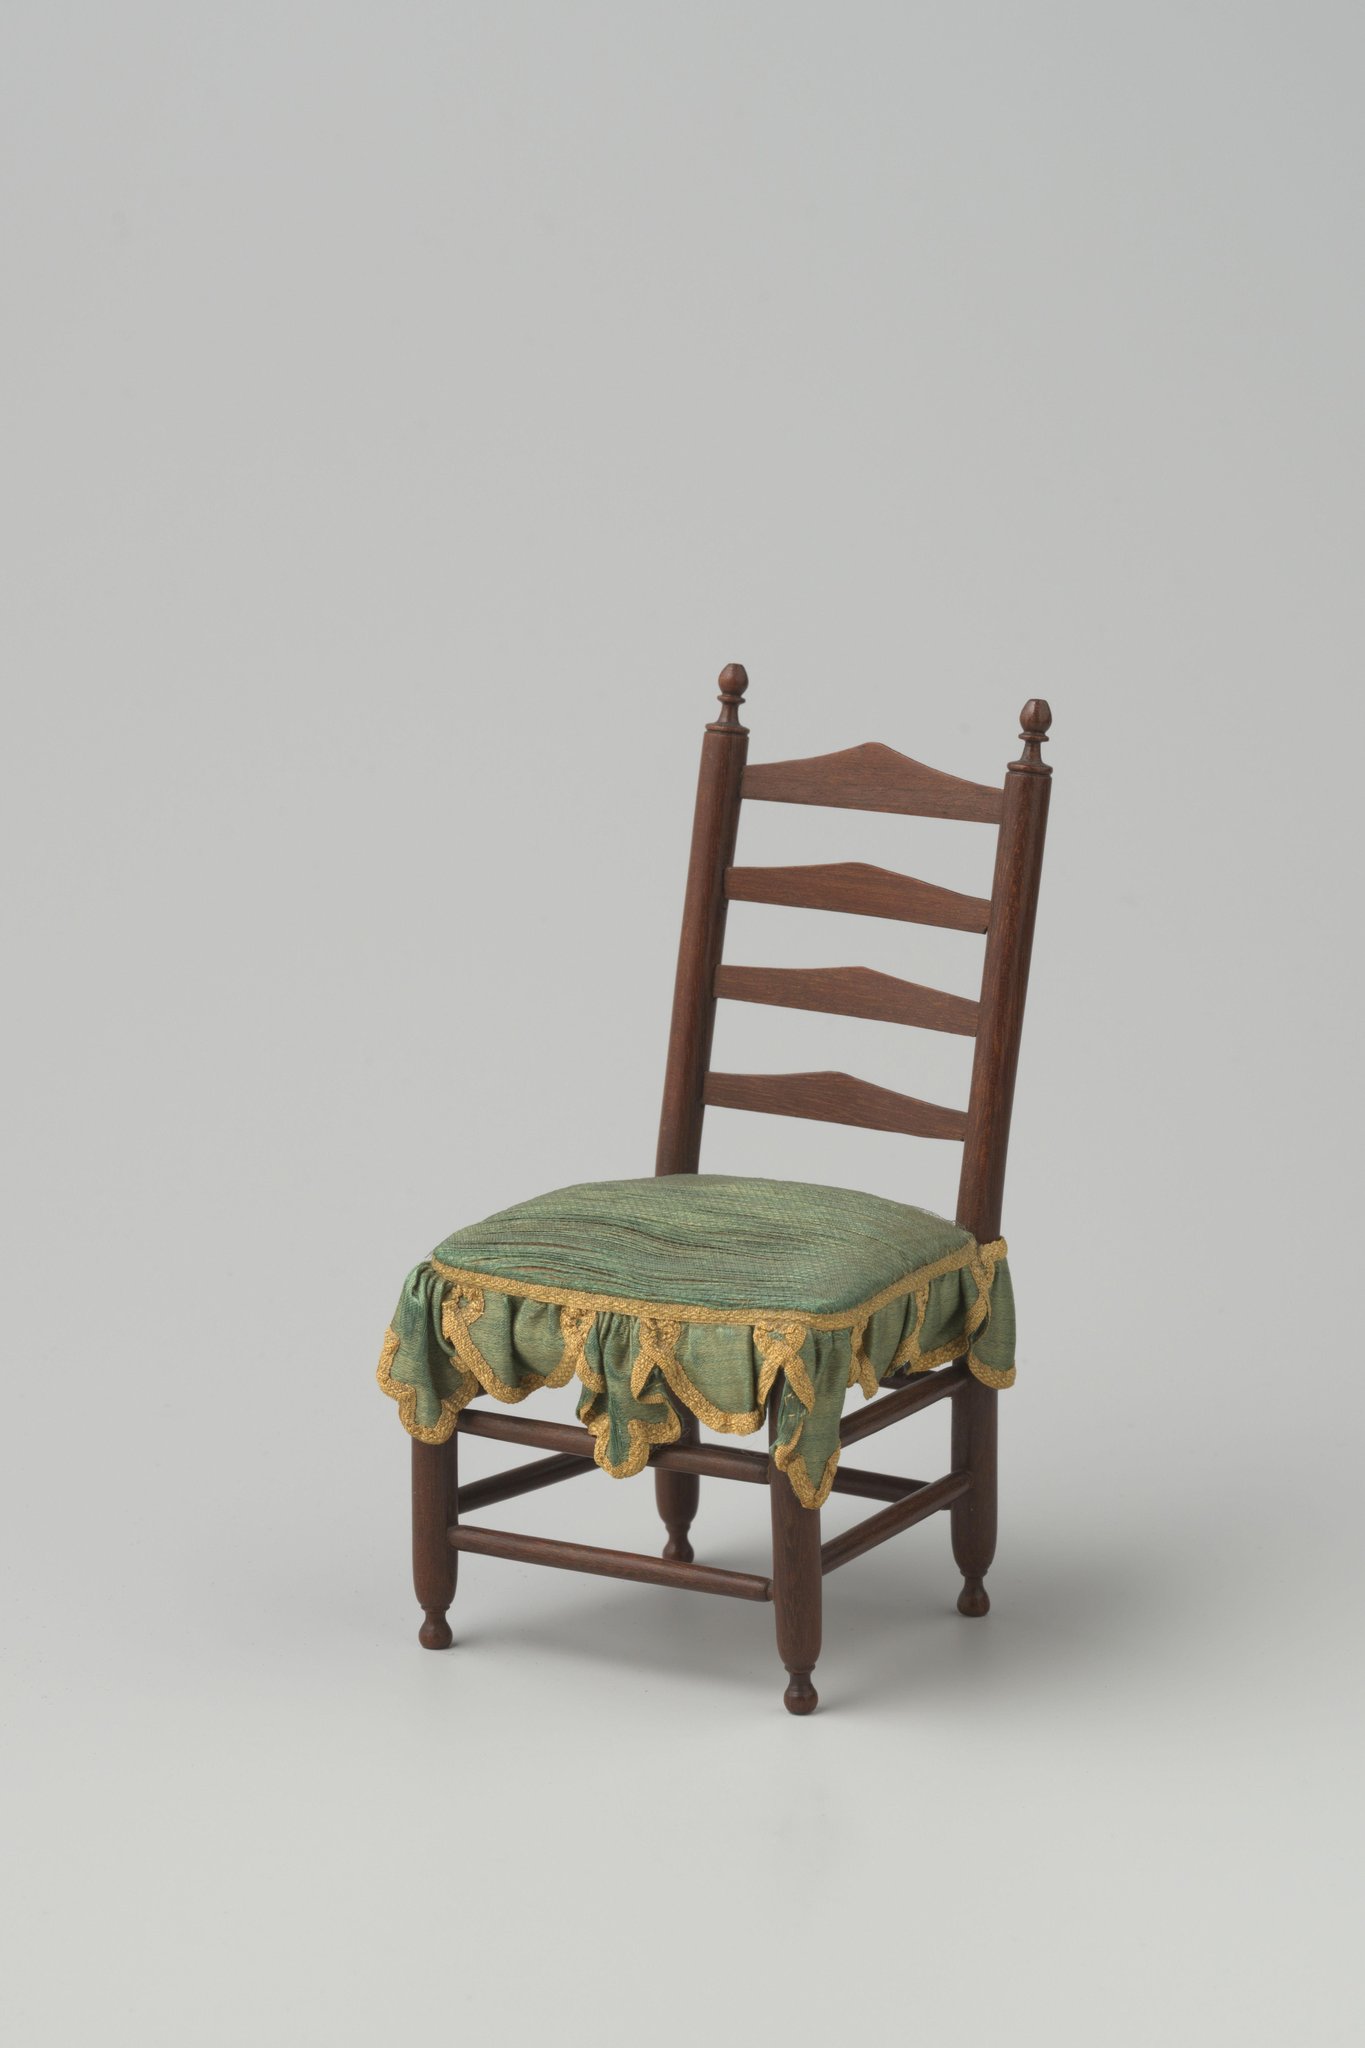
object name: chair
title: Knopstoel vervaardigd van hardhout met gladde, gedraaide stijlen en dwarsregels, voorpoten en achterstijlen eindigend in fijn gedraaide knoppen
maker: Anonymous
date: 1690-1710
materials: wood, silk, fiber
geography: amsterdam